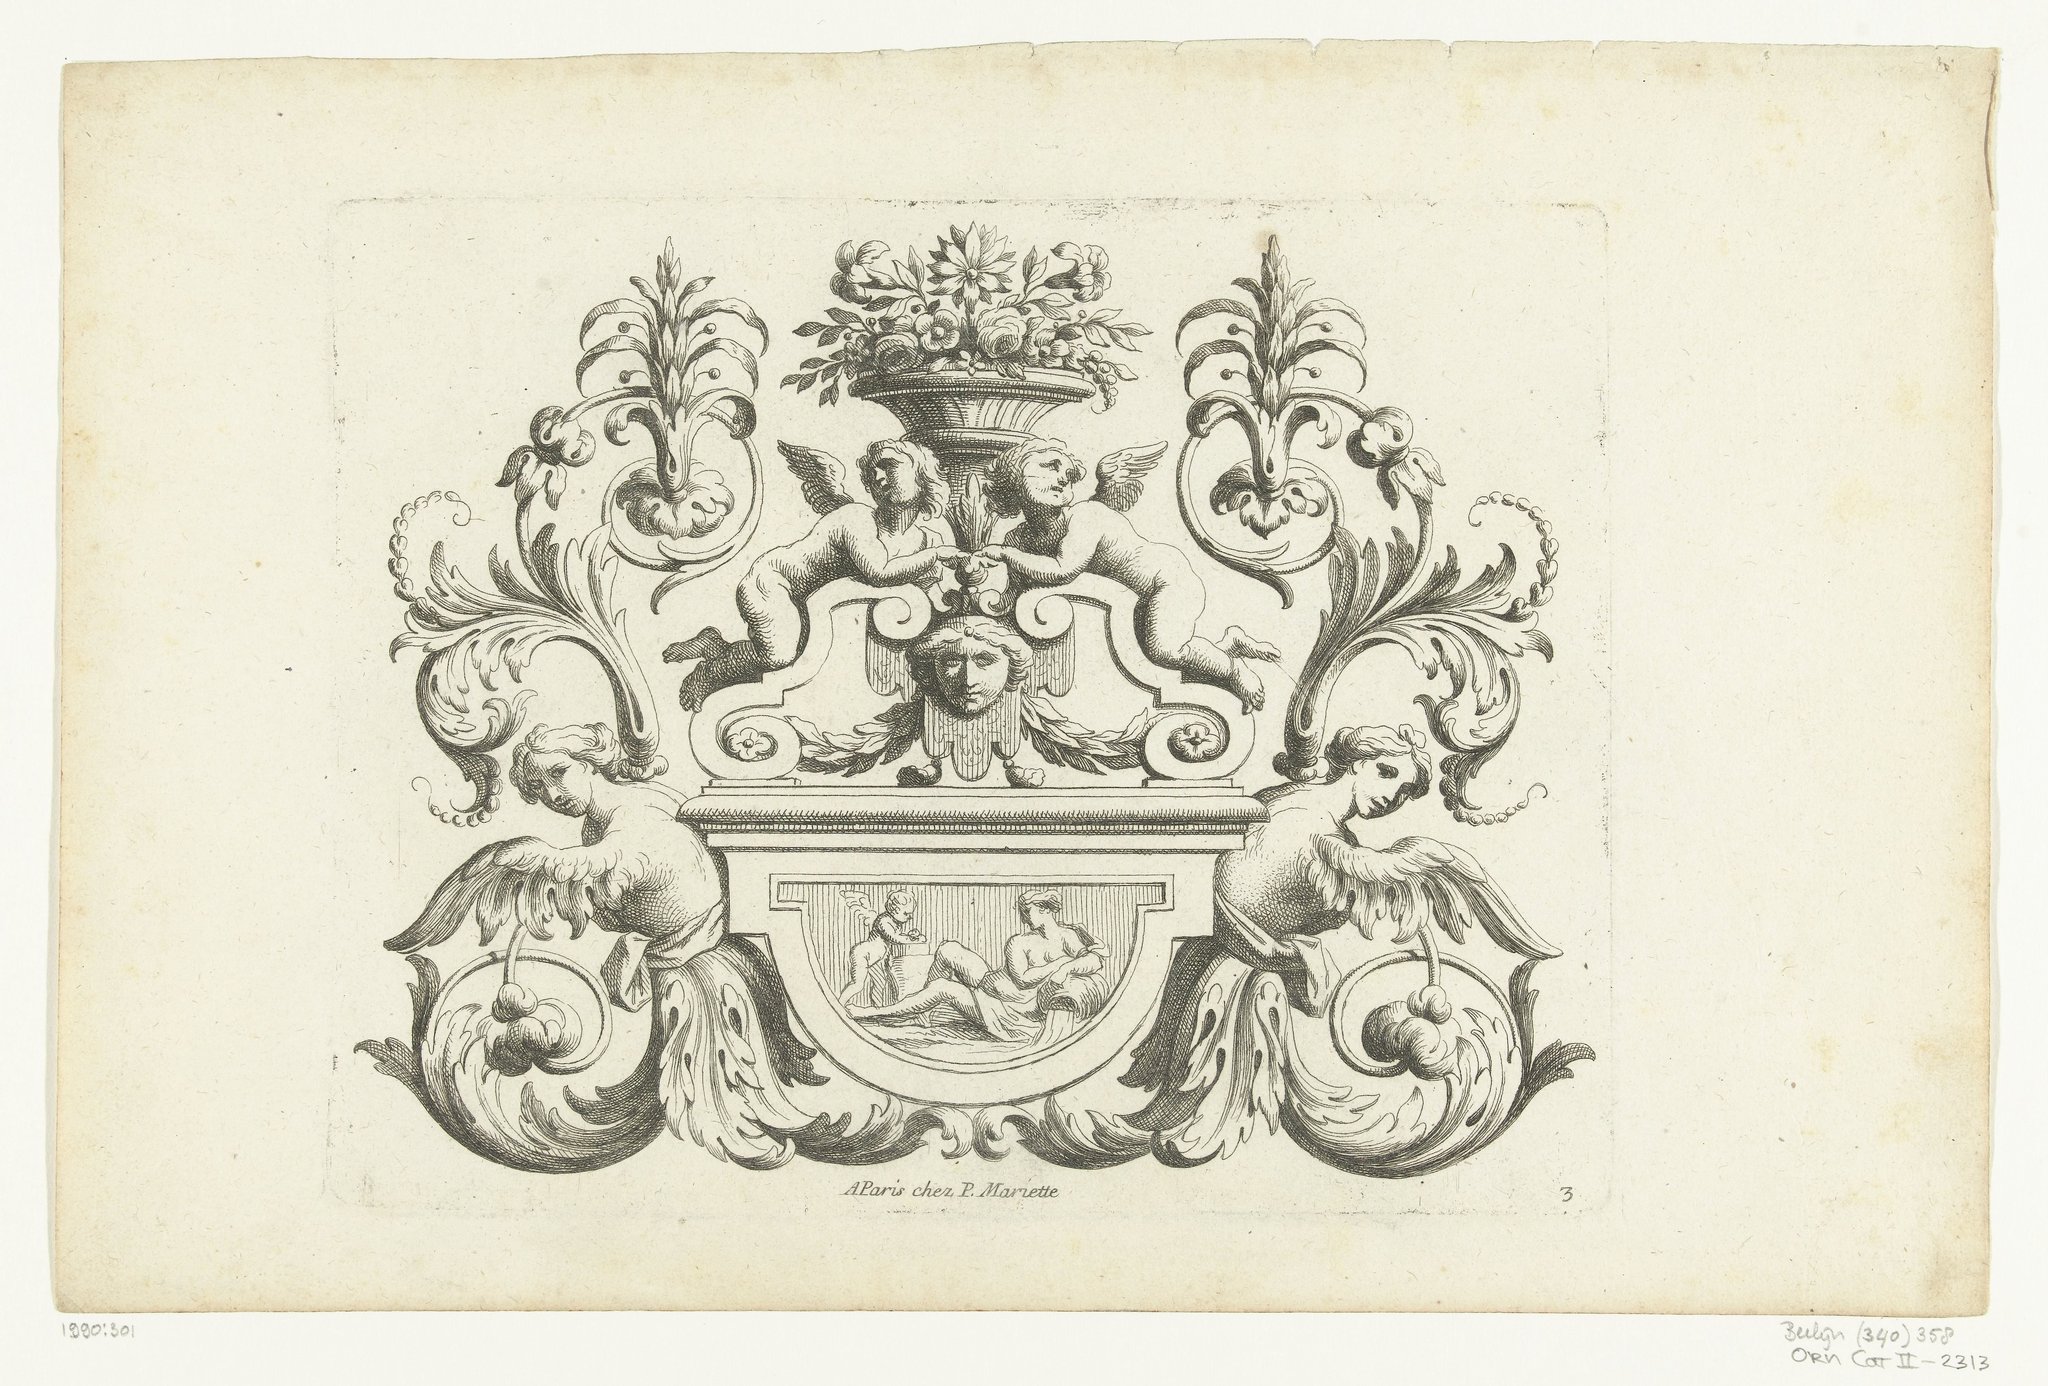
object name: ornament print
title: Paneel met Venus en Cupido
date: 1670-1680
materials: paper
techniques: engraving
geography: paris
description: Aan weerszijden van het paneel is een vrouwelijk bovenlichaam te zien met een vleugel en een bladrank als armen. Blad uit eerste editie.